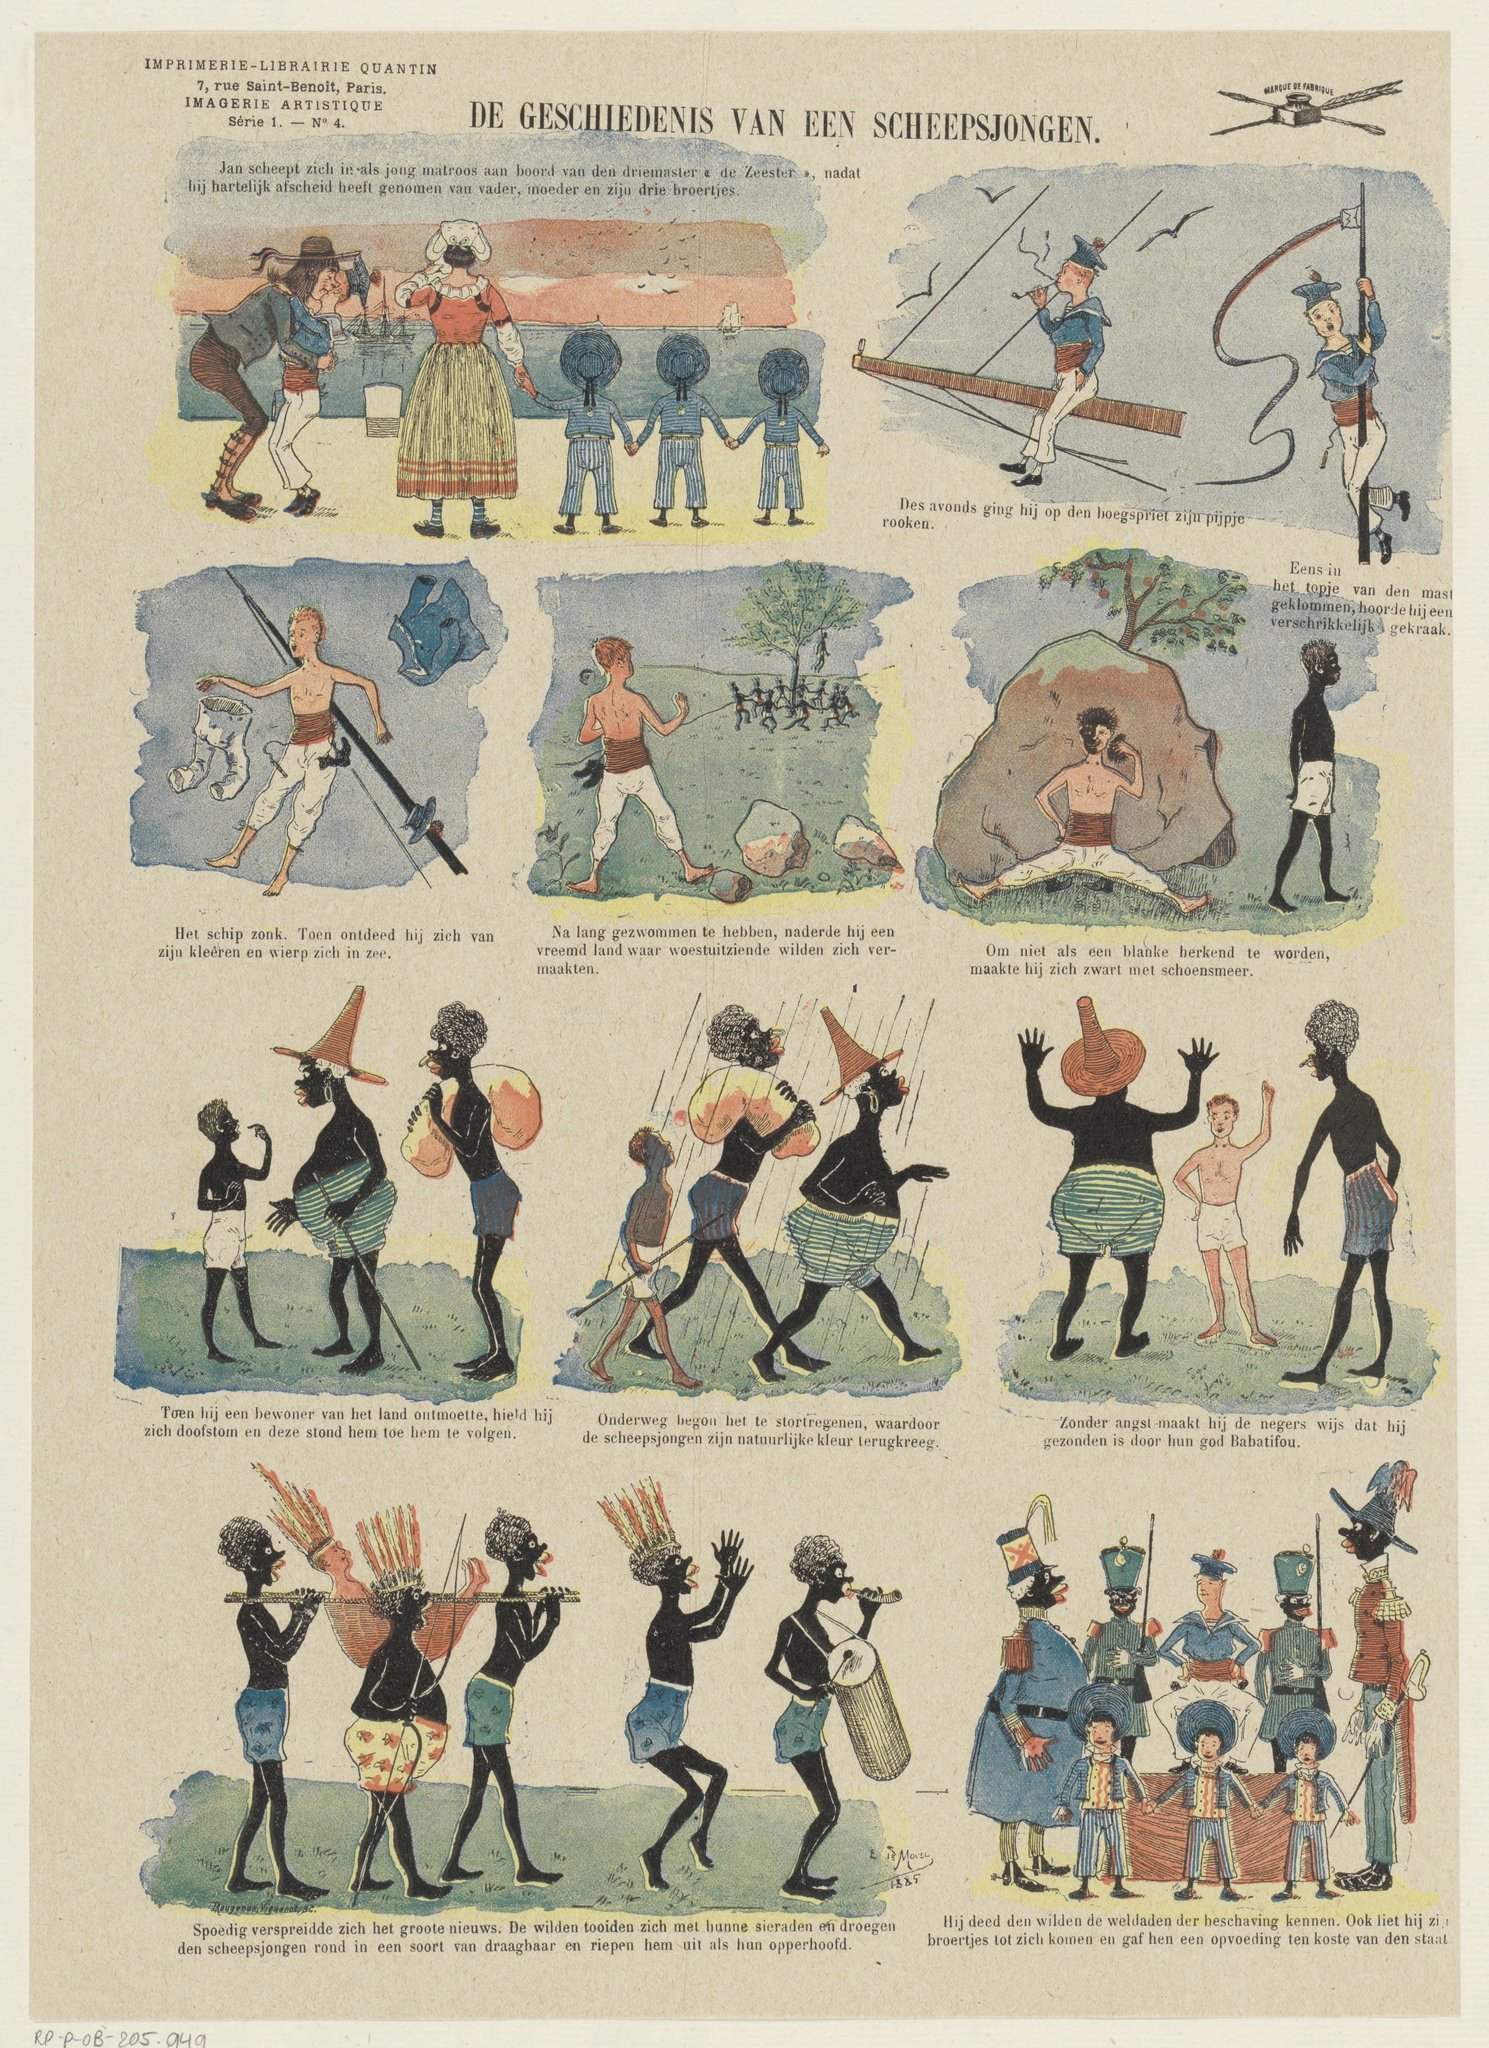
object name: print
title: Imagerie Artistique / Série 1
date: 1876-1890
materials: paper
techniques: lithograph, letterpress printing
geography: paris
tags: africans, shipwreck, tales and fairy tales, seaman: sailor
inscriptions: collector's mark: Lugt 2760, : ‘marque de fabrique / deposée’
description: Blad met 10 voorstellingen over het leven van een scheepsjongen. Onder elke voorstelling een onderschrift. Genummerd linksboven: Série 1. - No. 4.